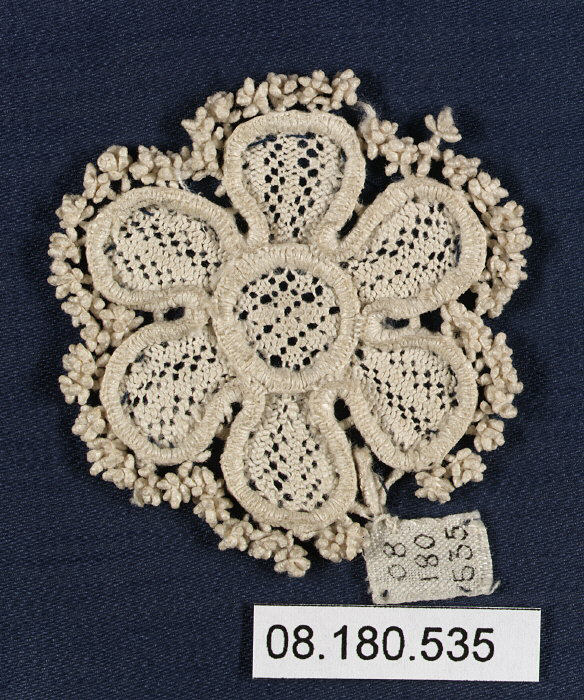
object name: ornament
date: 1601-1700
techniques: lace